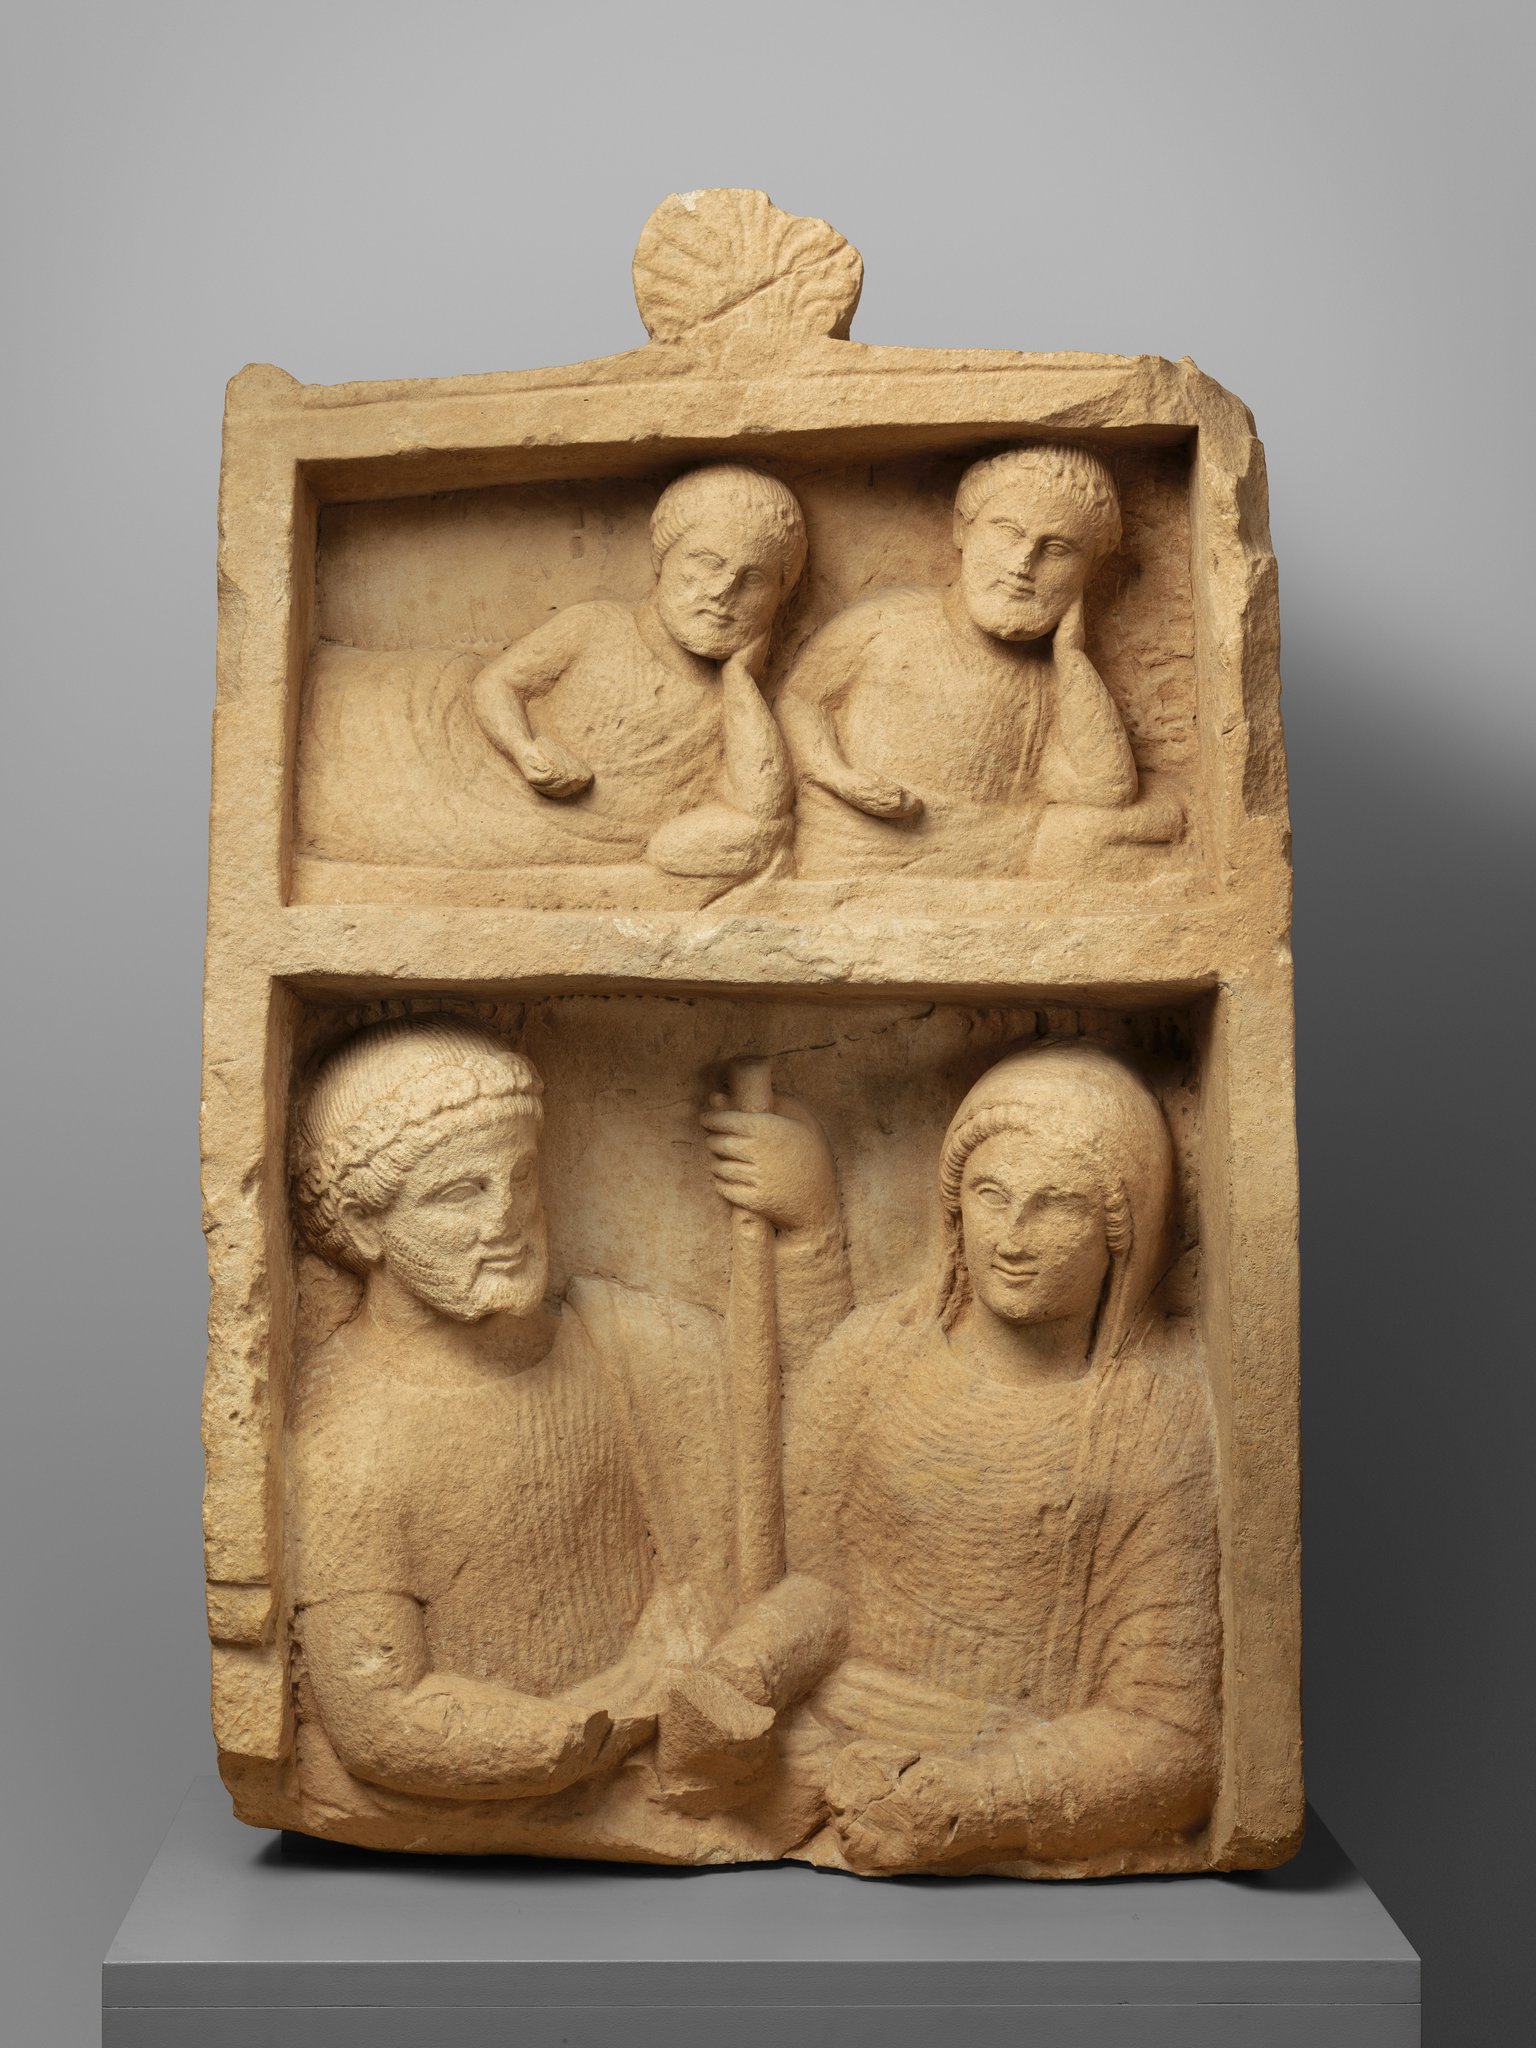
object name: grave stele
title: Limestone grave marker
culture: cypriot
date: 400-301 BCE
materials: limestone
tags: men,women